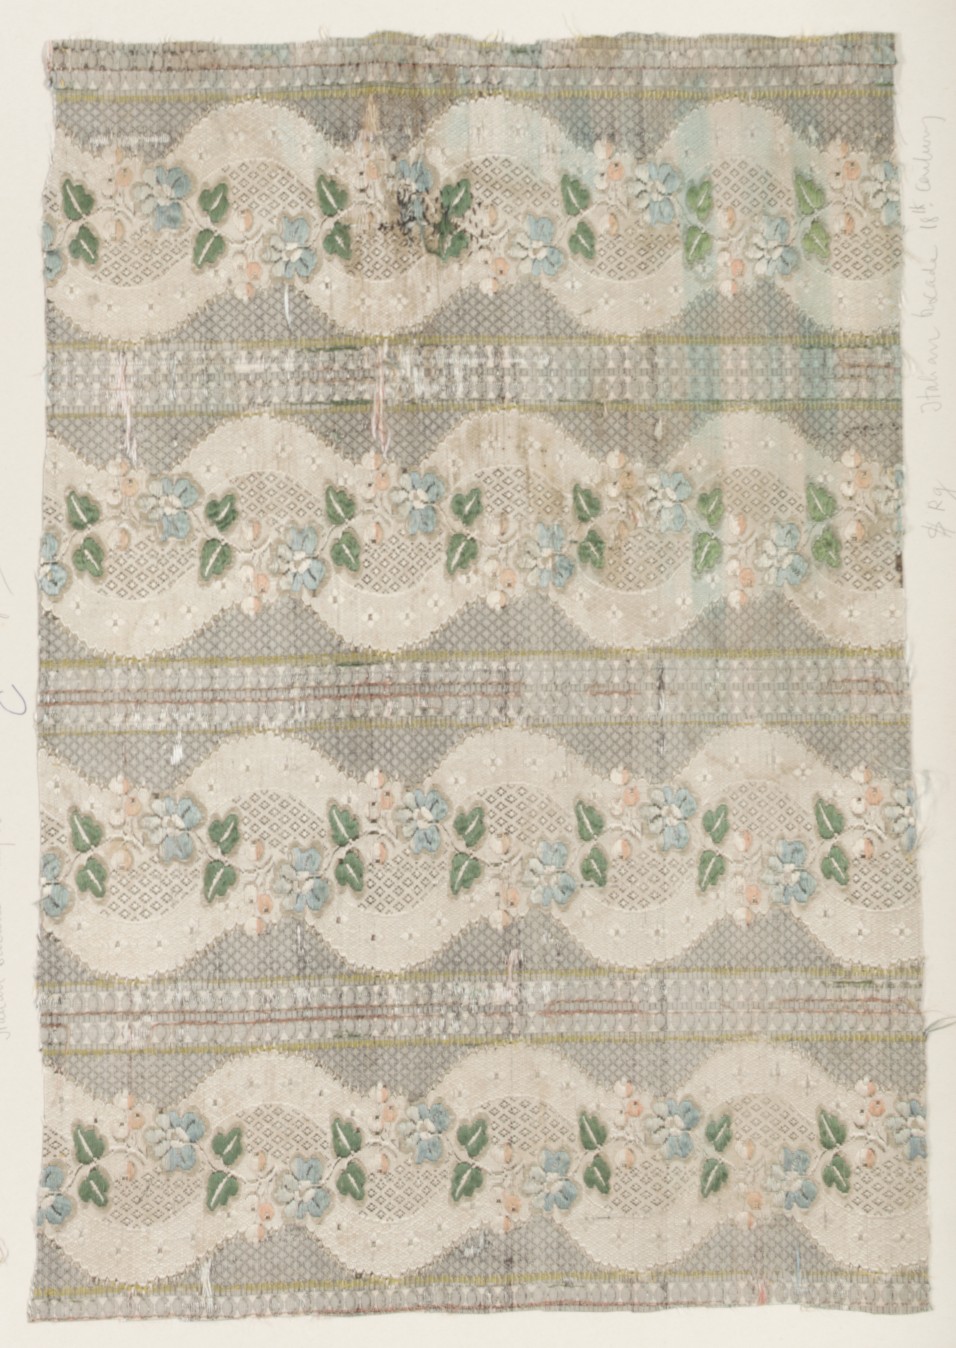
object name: fragment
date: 1701-1800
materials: silk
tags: flowers,leaves